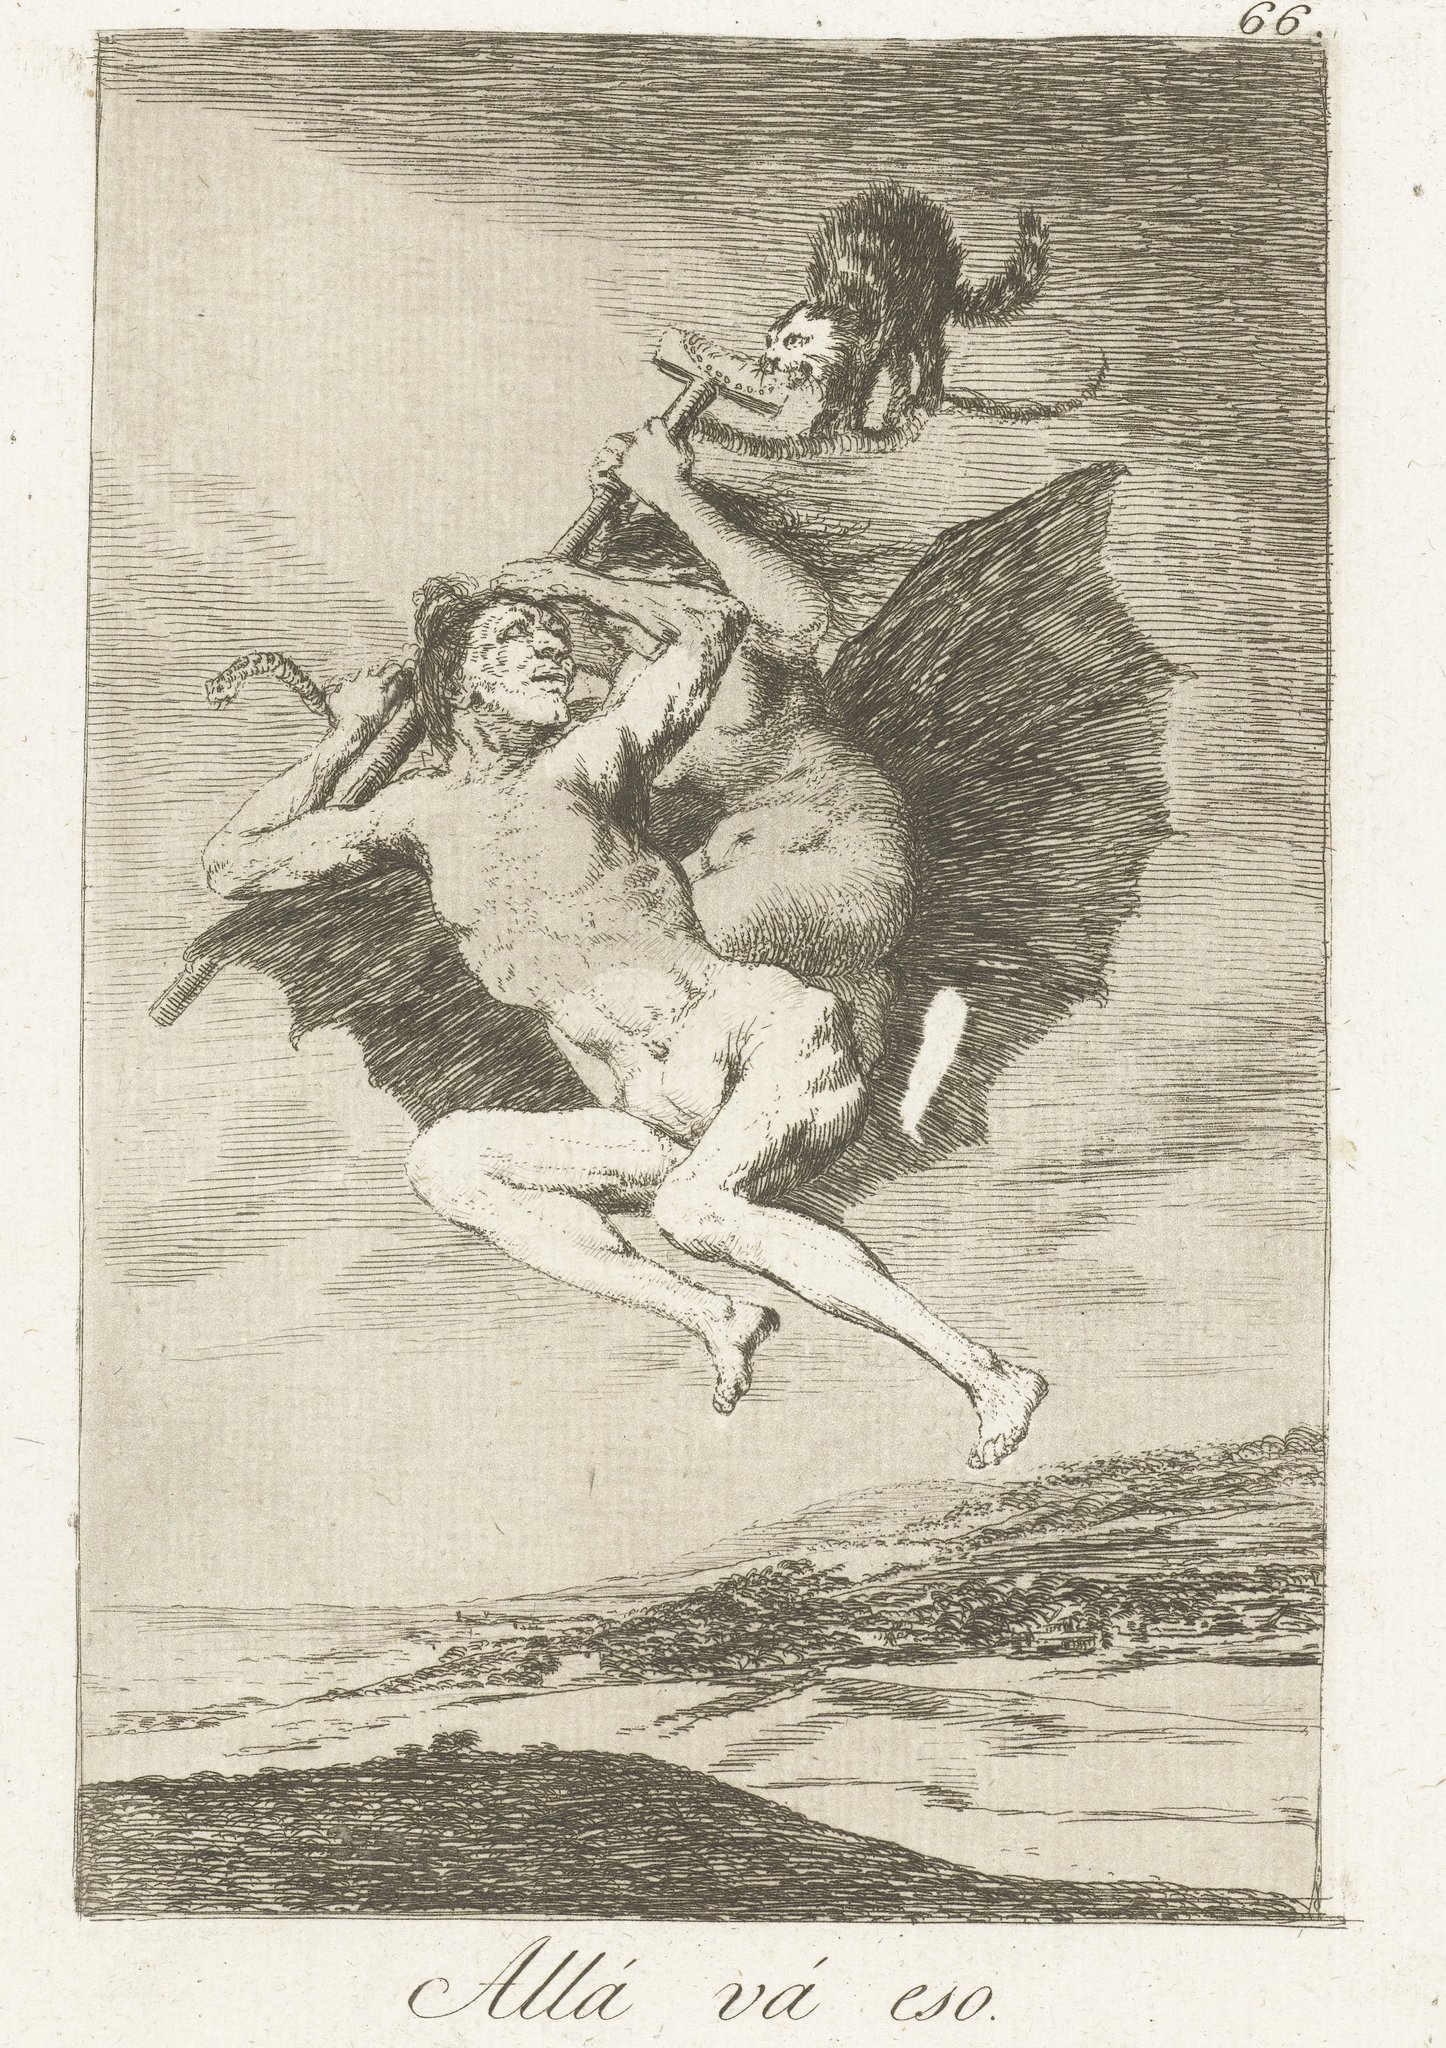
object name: print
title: Allá vá eso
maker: francisco de goya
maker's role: draughtsman, painter, print maker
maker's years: 1746-1828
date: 1797-1799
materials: paper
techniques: aquatint, drypoint, etching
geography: spain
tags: witch, sorceress, flying, human-shaped devil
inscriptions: collector's mark: Lugt 2228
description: Een heks en een duivel in de lucht, hangend aan een stok en een slang. Op de staart van de slang staat een kat. Zesenzestigste prent uit de serie Los Caprichos.